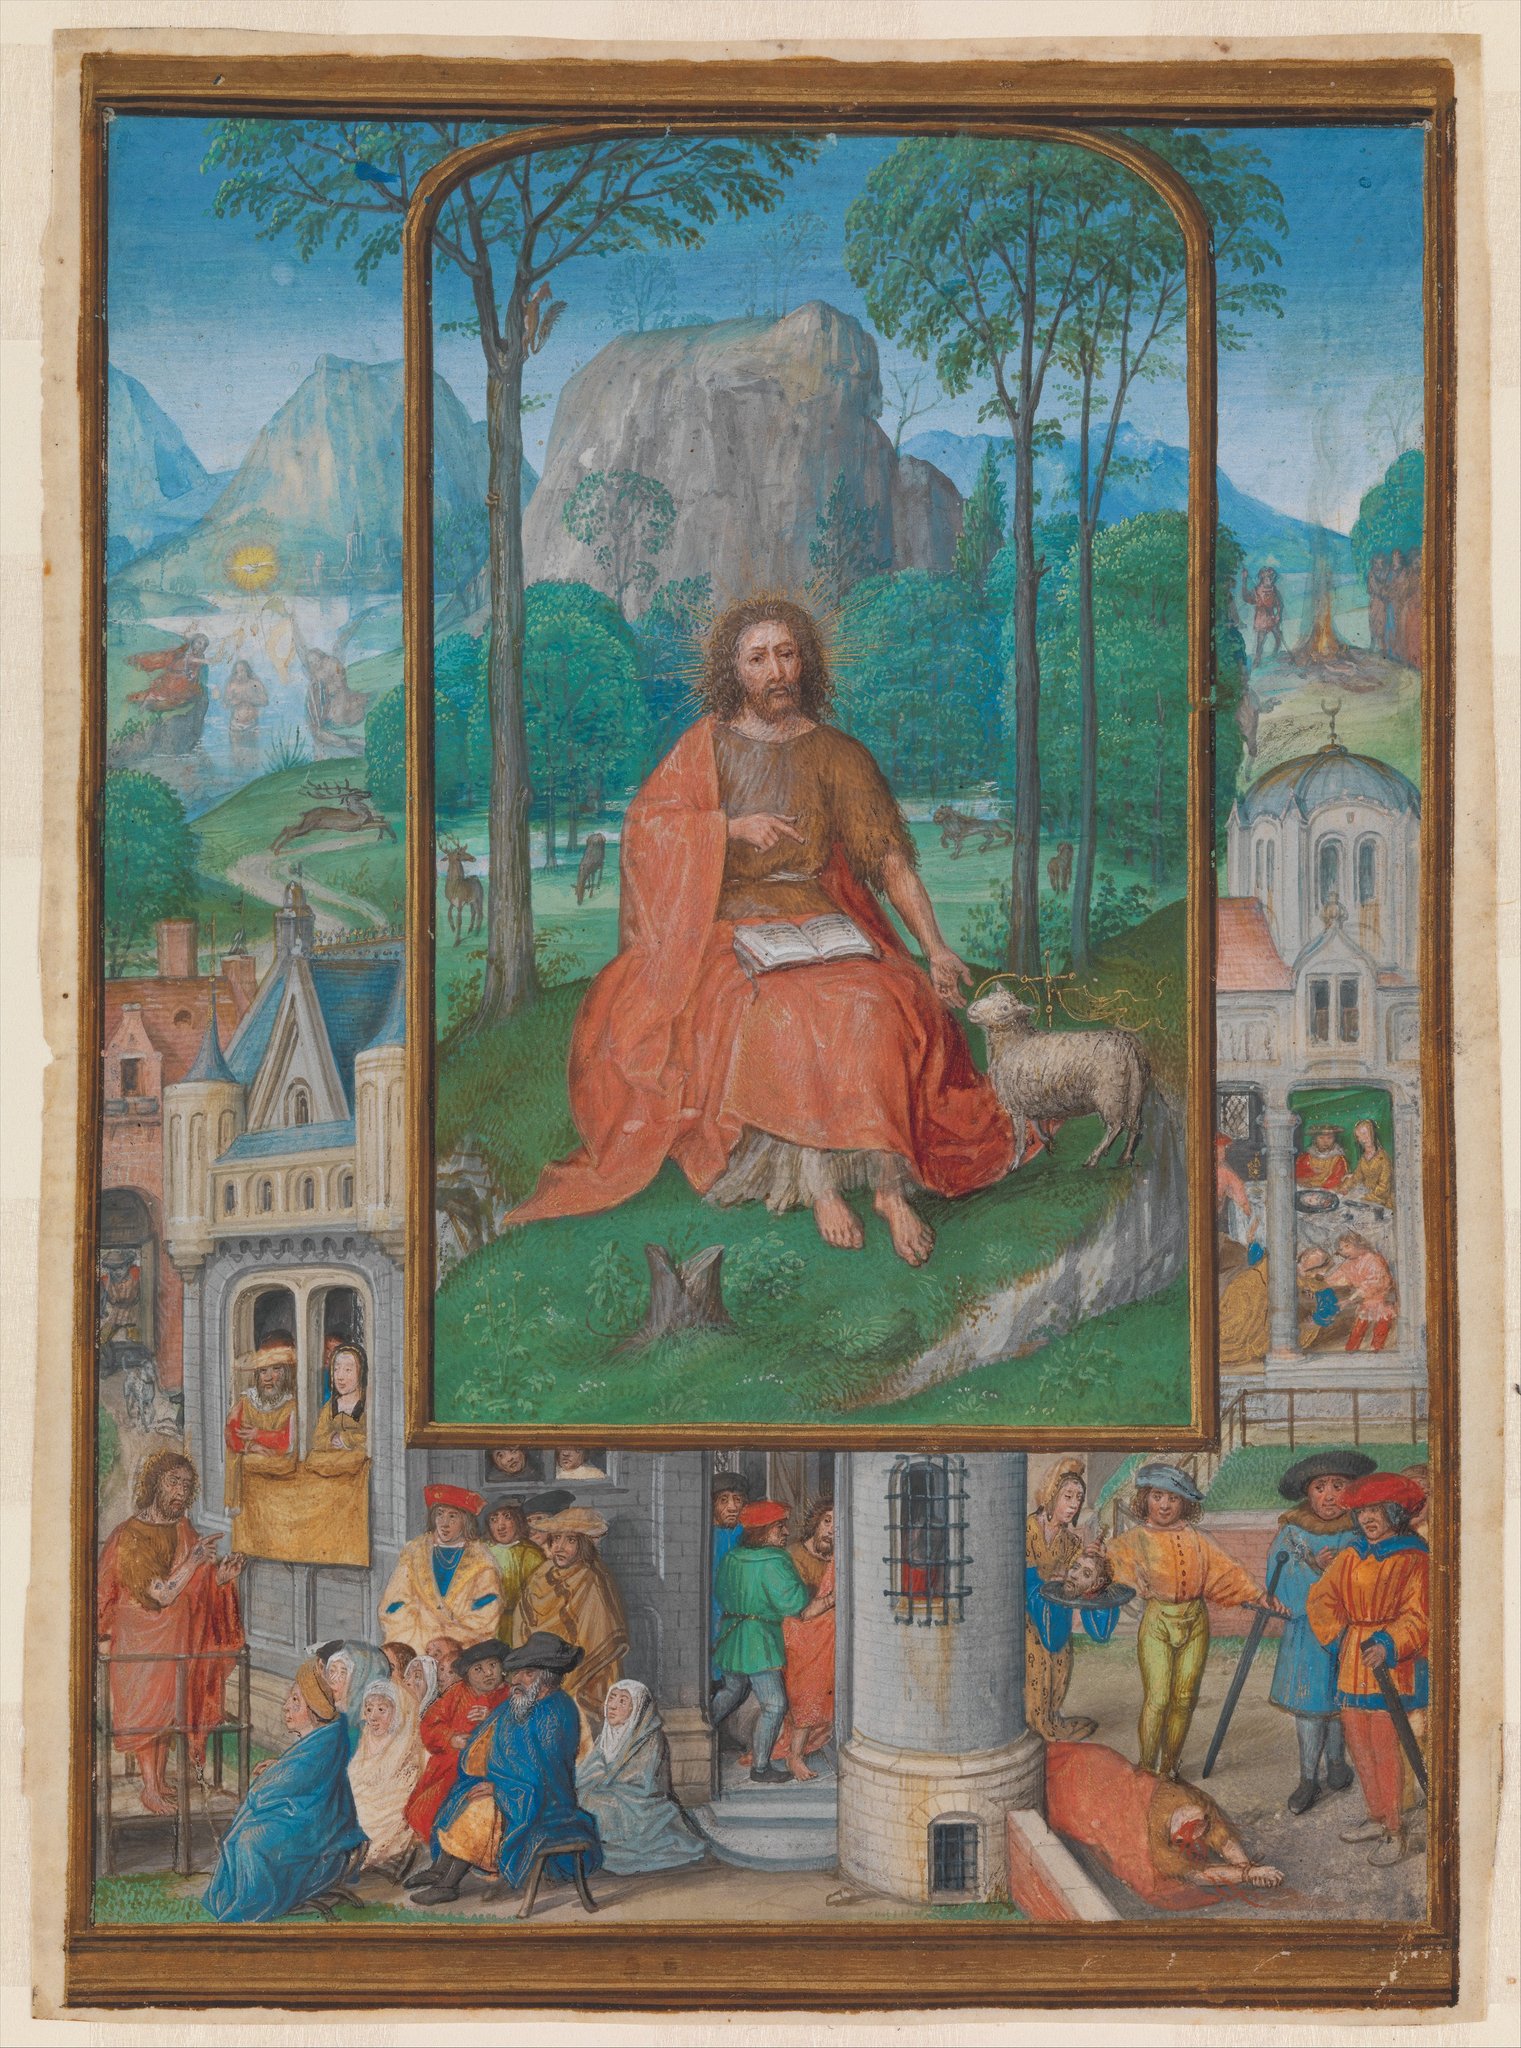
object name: manuscript cutting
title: Manuscript Illumination with Scenes from the Life of Saint John the Baptist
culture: dutch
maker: master of james iv of scotland (probably gerard horenbout)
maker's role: artist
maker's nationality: netherlandish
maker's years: 1480-1535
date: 1515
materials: gold, ink, parchment, shell, paint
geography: netherlands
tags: men,women,lambs,saint john the baptist